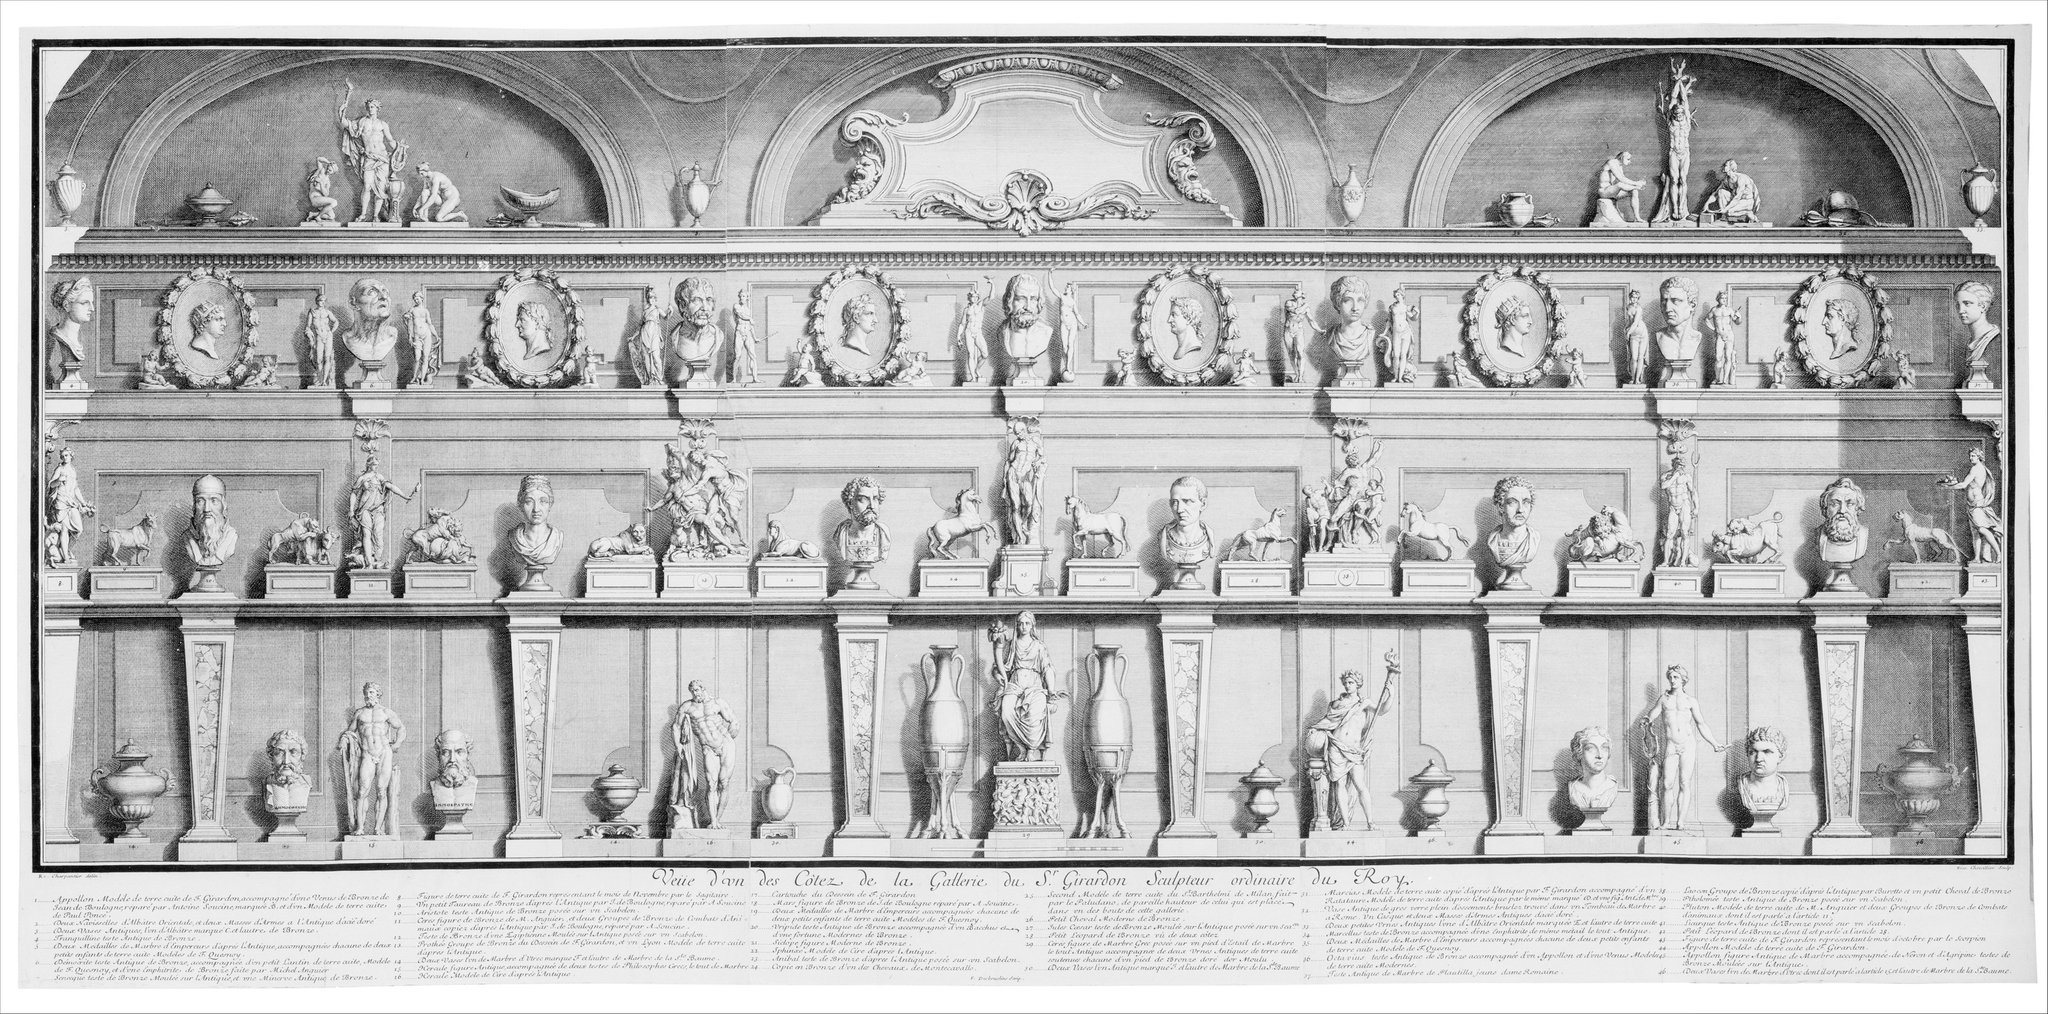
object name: print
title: La Galerie de Girardon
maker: nicolas chevalier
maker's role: artist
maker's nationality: french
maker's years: 1700-1800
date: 1701-1800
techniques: engraving, etching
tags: men,portraits,profiles,women,horses